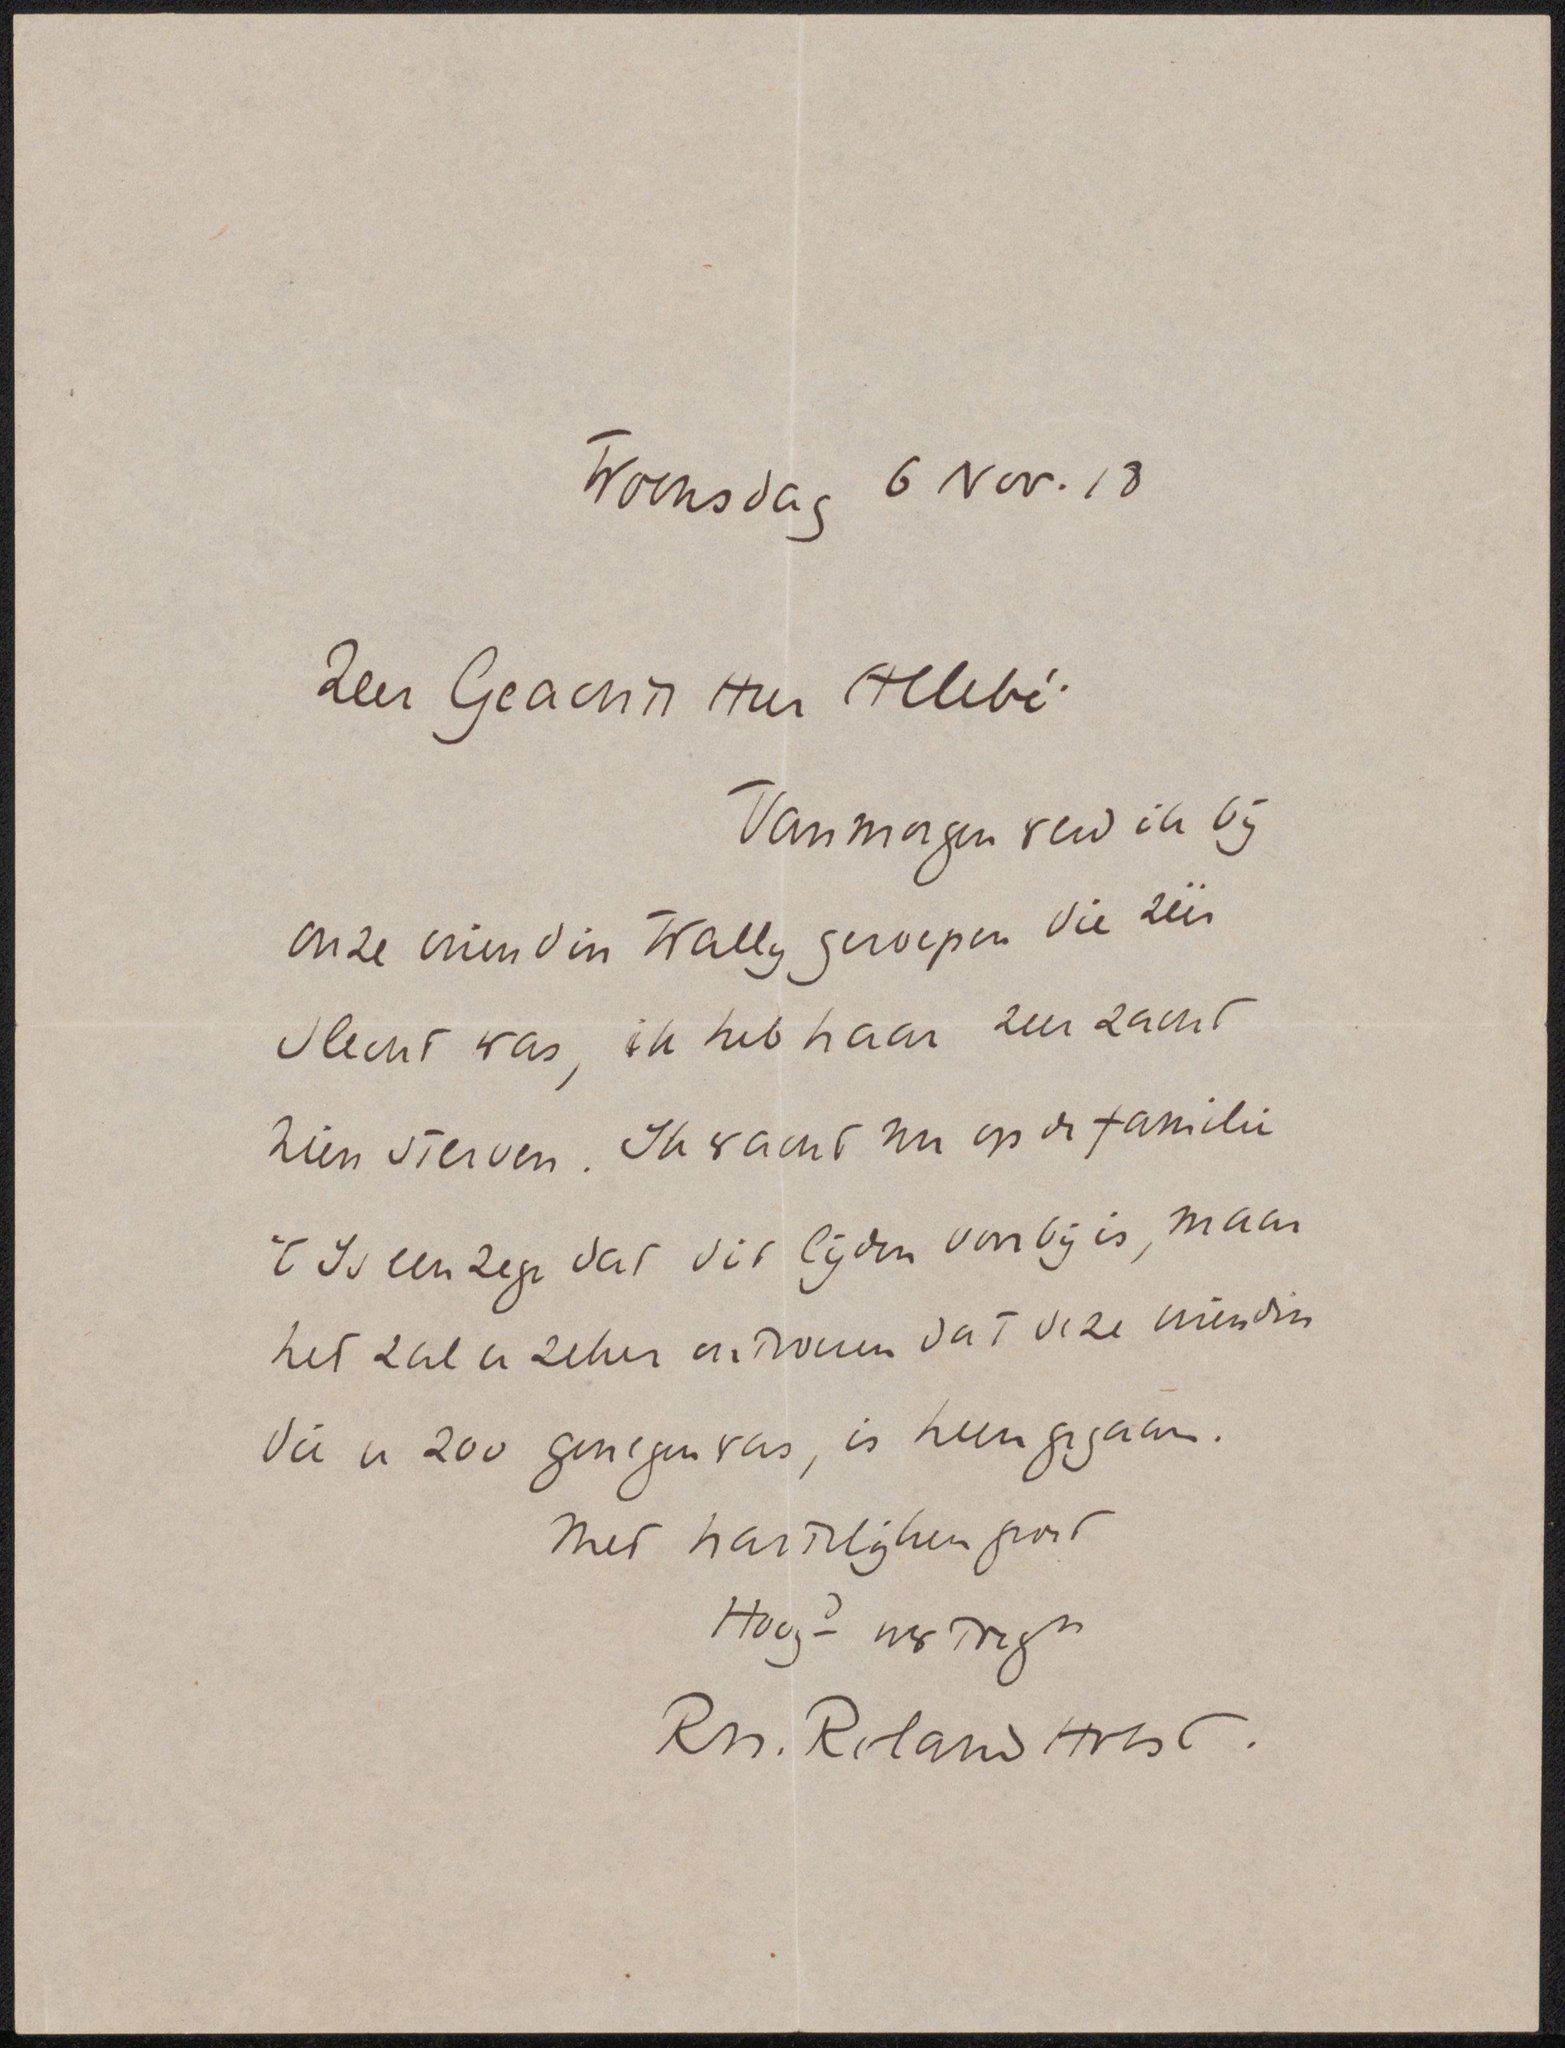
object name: letter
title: Brief aan August Allebé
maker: richard nicolaüs roland holst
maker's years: 1868-1938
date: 1918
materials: ink, paper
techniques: pen, writing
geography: laren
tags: august allebé, amsterdam, print maker, draughtsman, wally moes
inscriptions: collector's mark: ‘RPK’